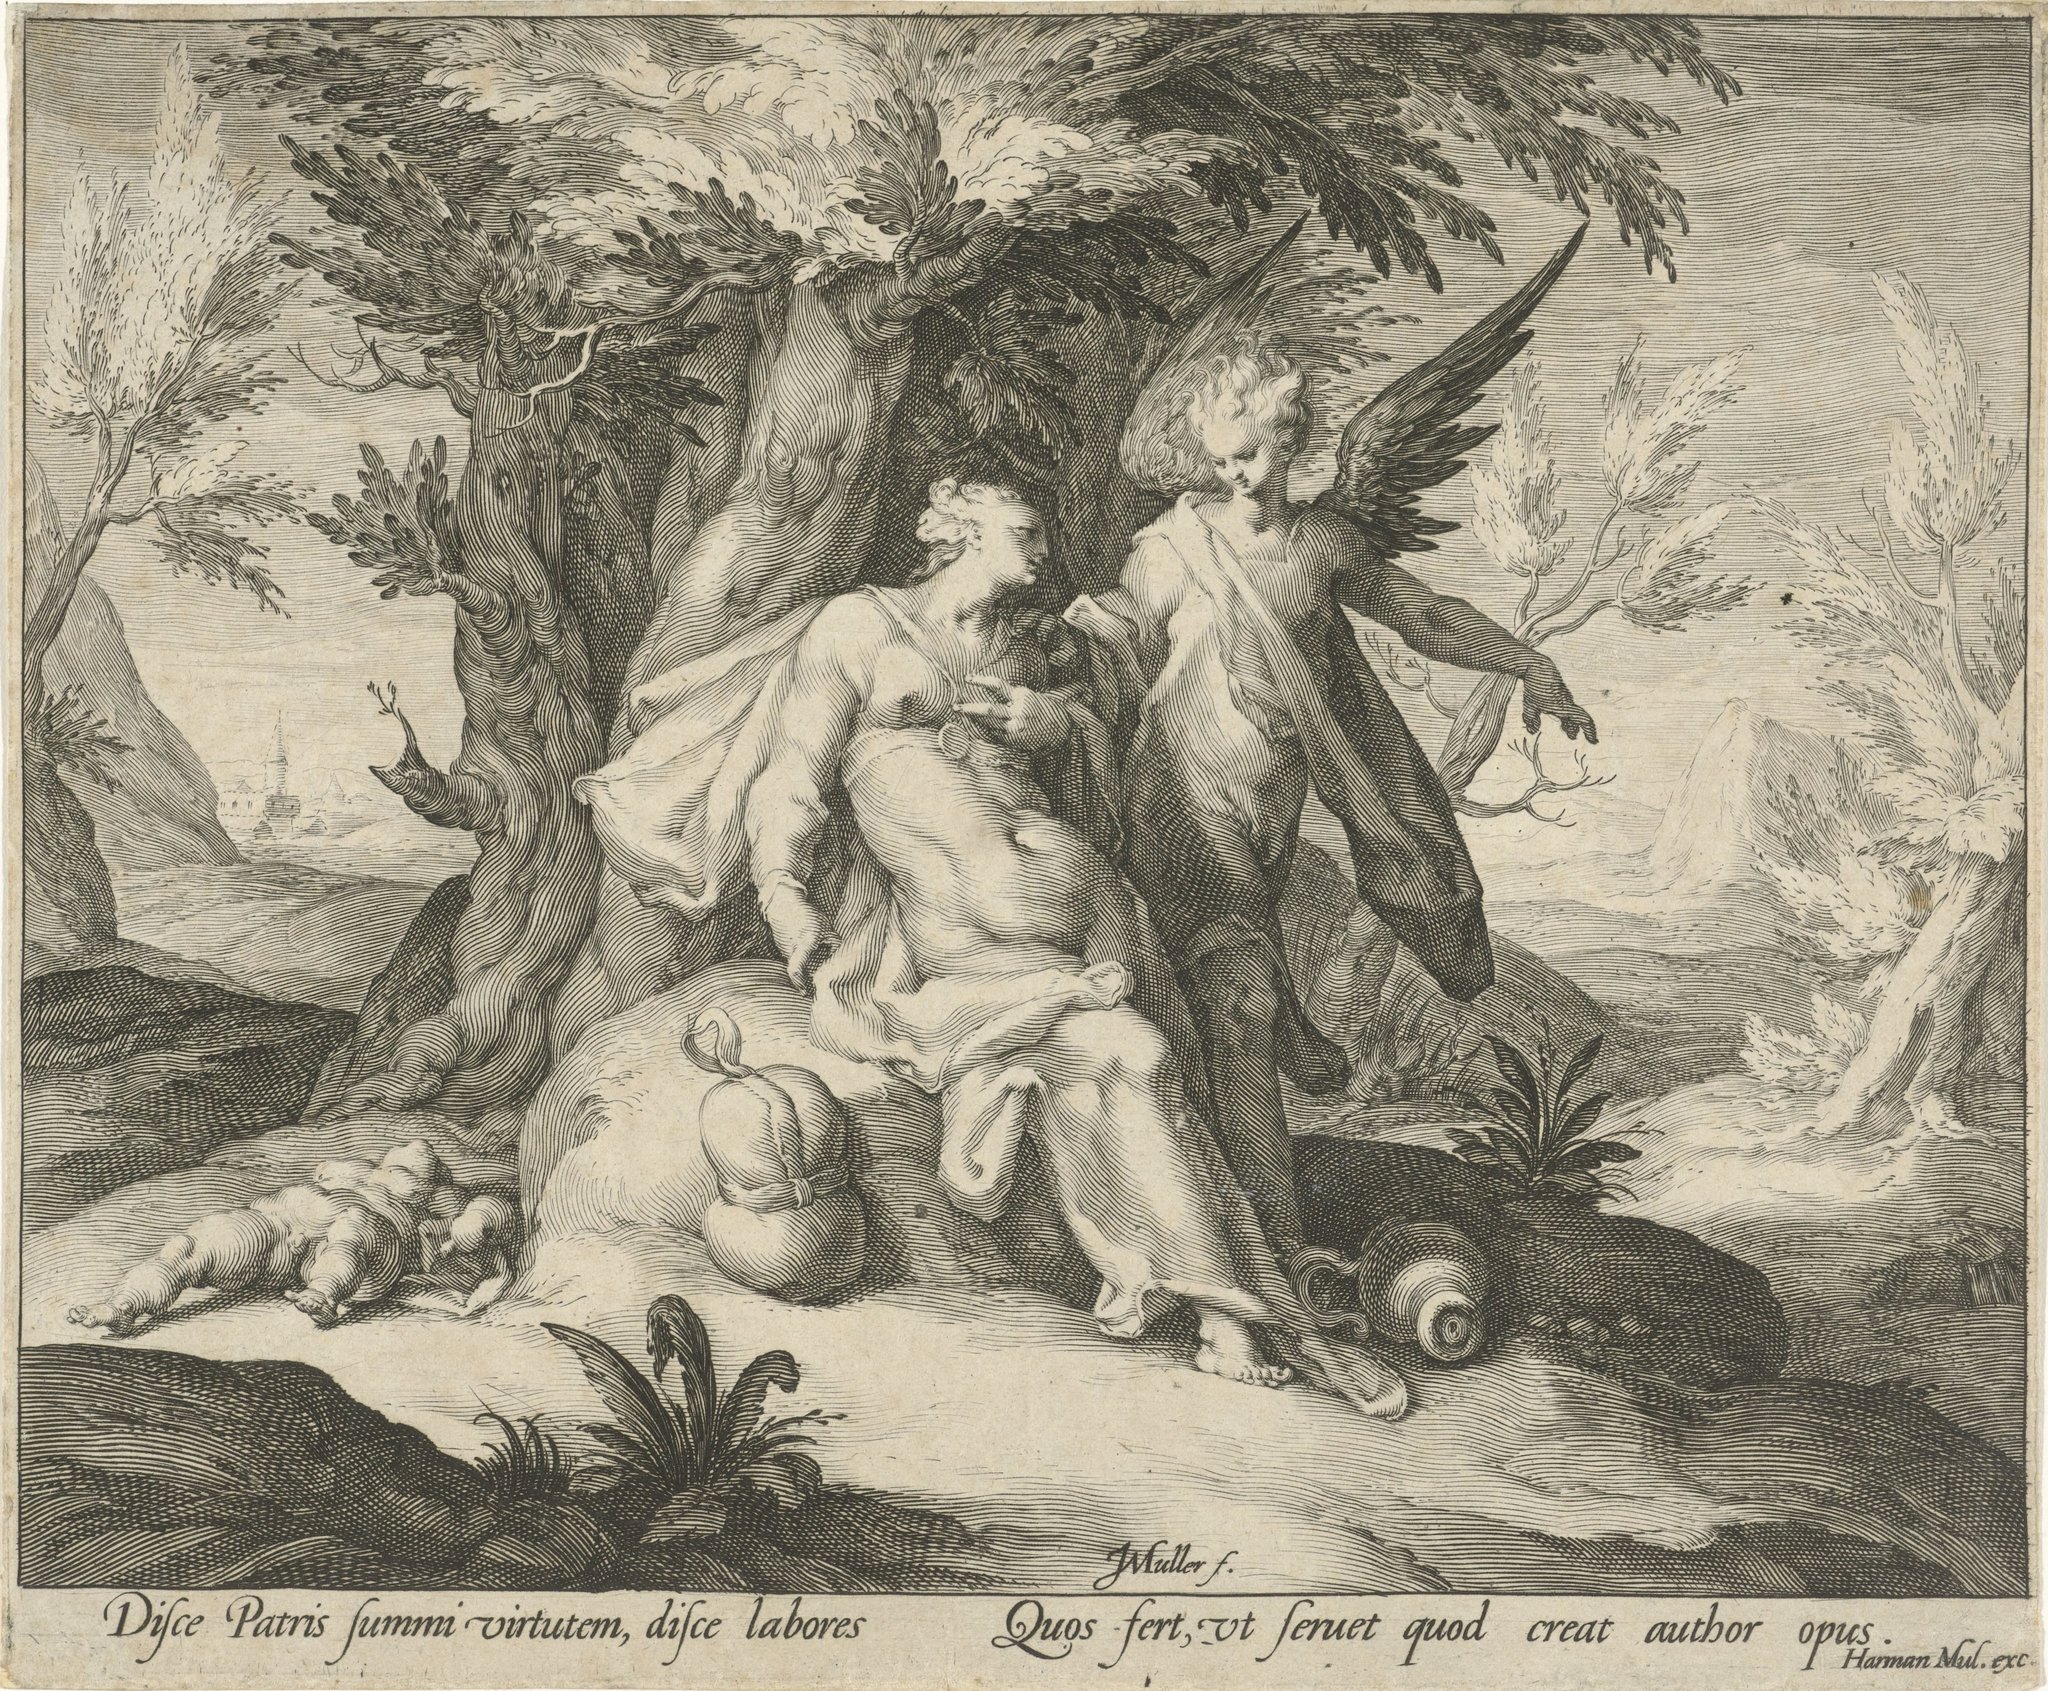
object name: print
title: Hagar en Ismaël in de woestijn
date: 1589-1593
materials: paper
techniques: engraving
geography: amsterdam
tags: an angel appears and reveals a well of water to hagar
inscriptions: collector's mark: Lugt 2228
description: Een engel wijst Hagar op een bron. Links ligt Ismaël. Naast Hagar een lege kruik. Onderaan in de marge een tekstregel in het Latijn.